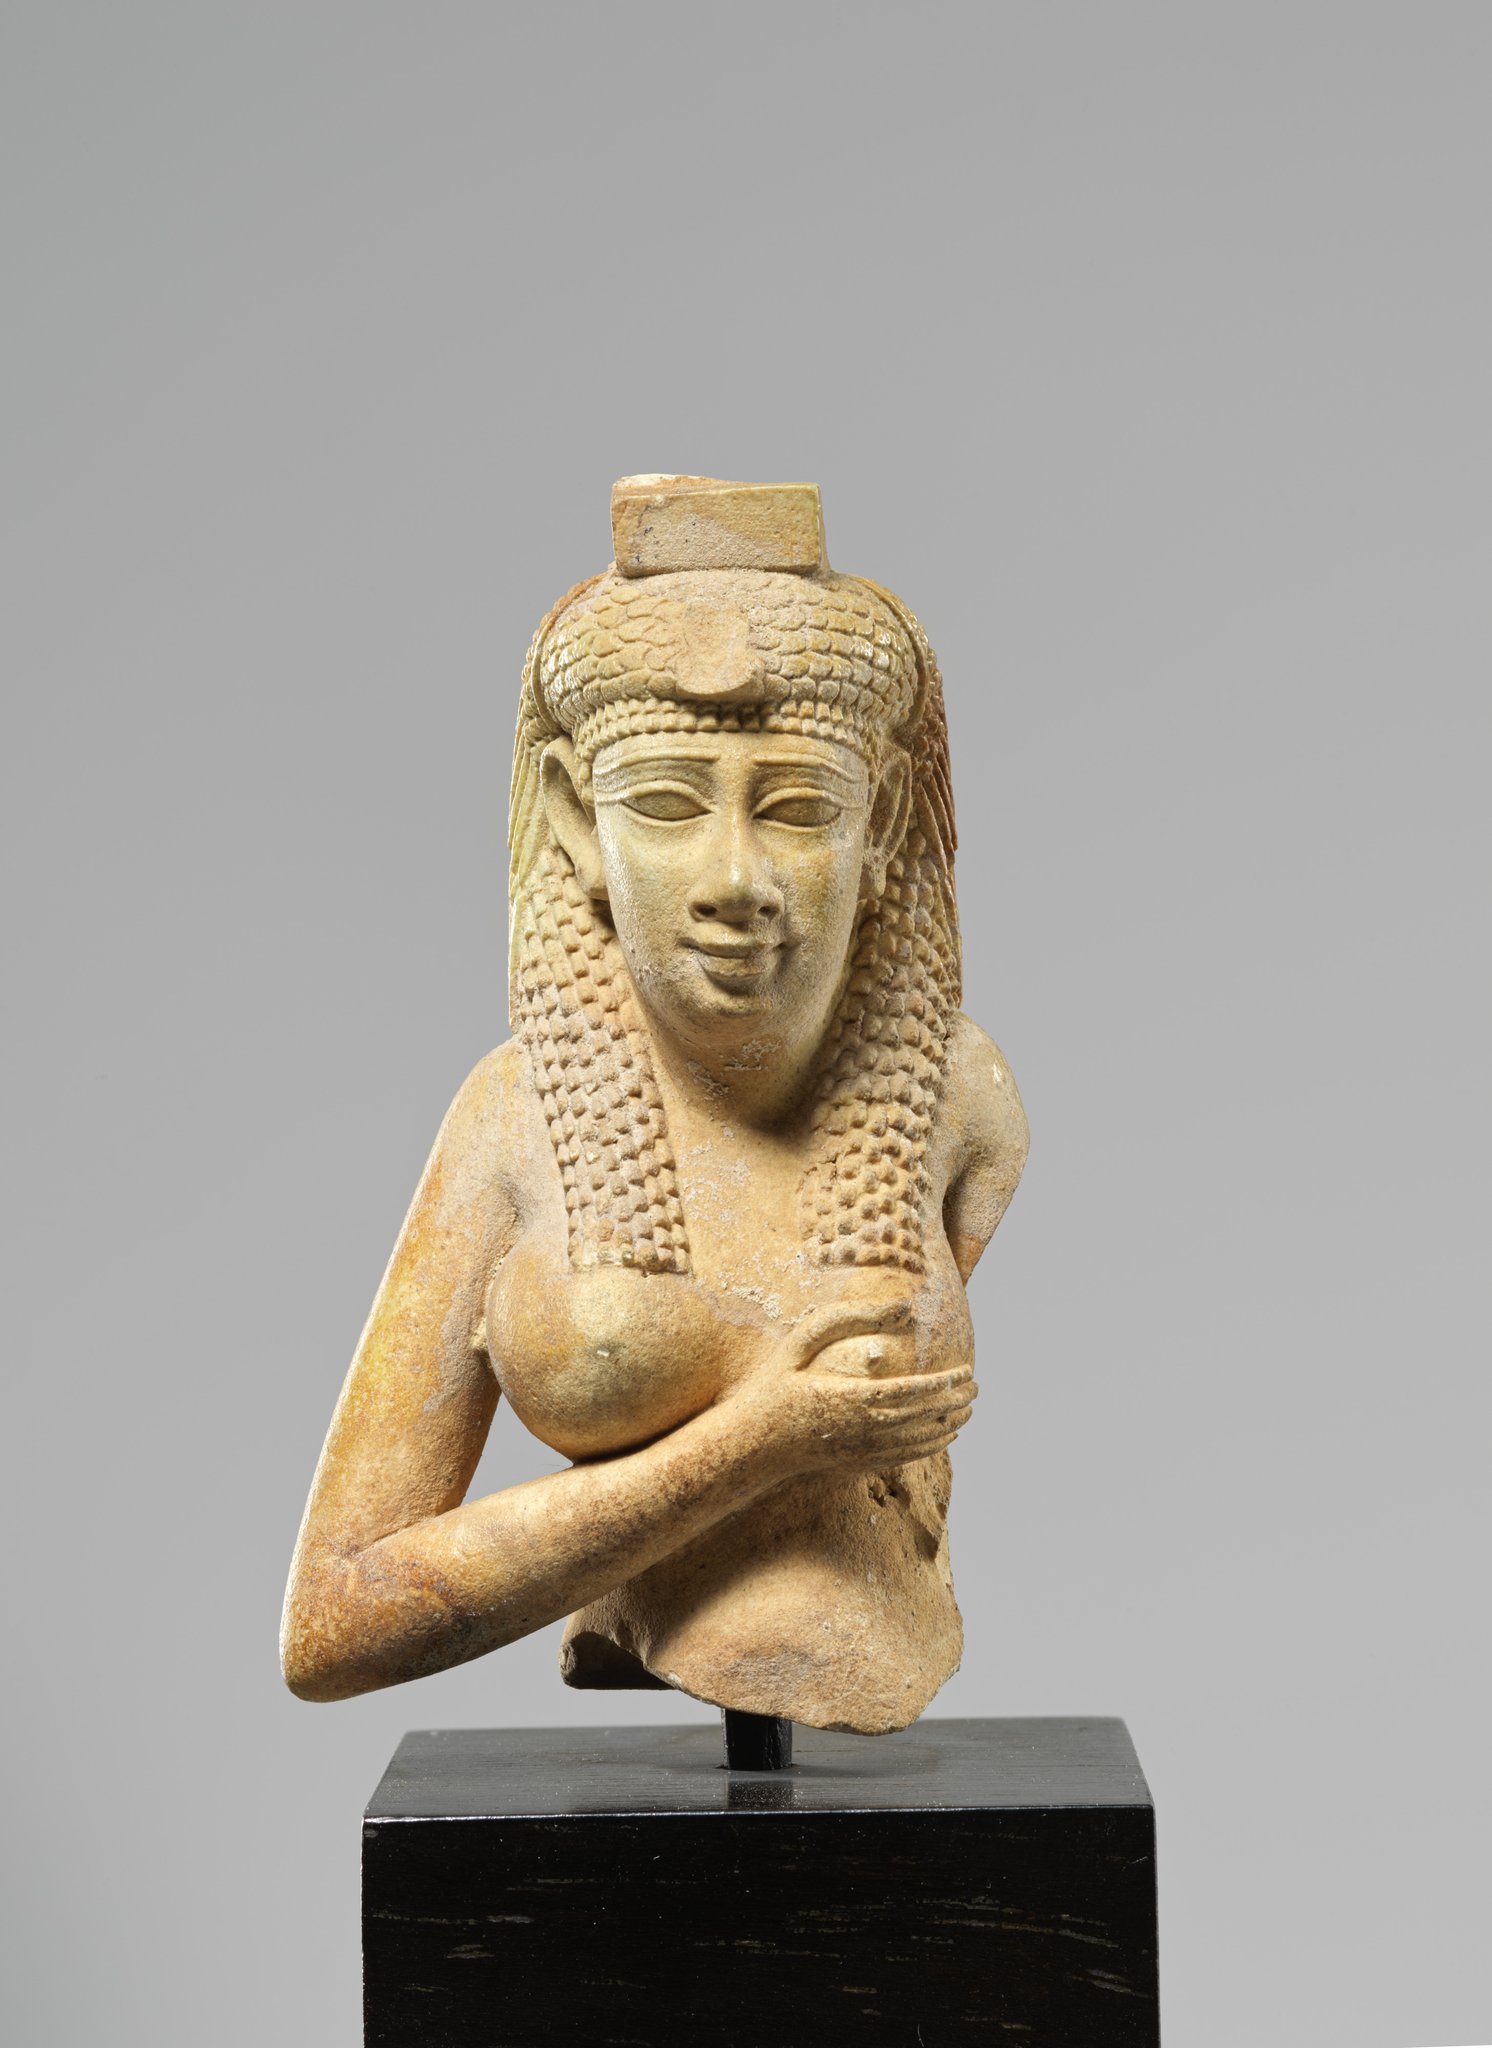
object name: upper part of a figure depicting isi nursing horus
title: Upper part of a figure of Isis nursing Horus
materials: faience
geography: egypt